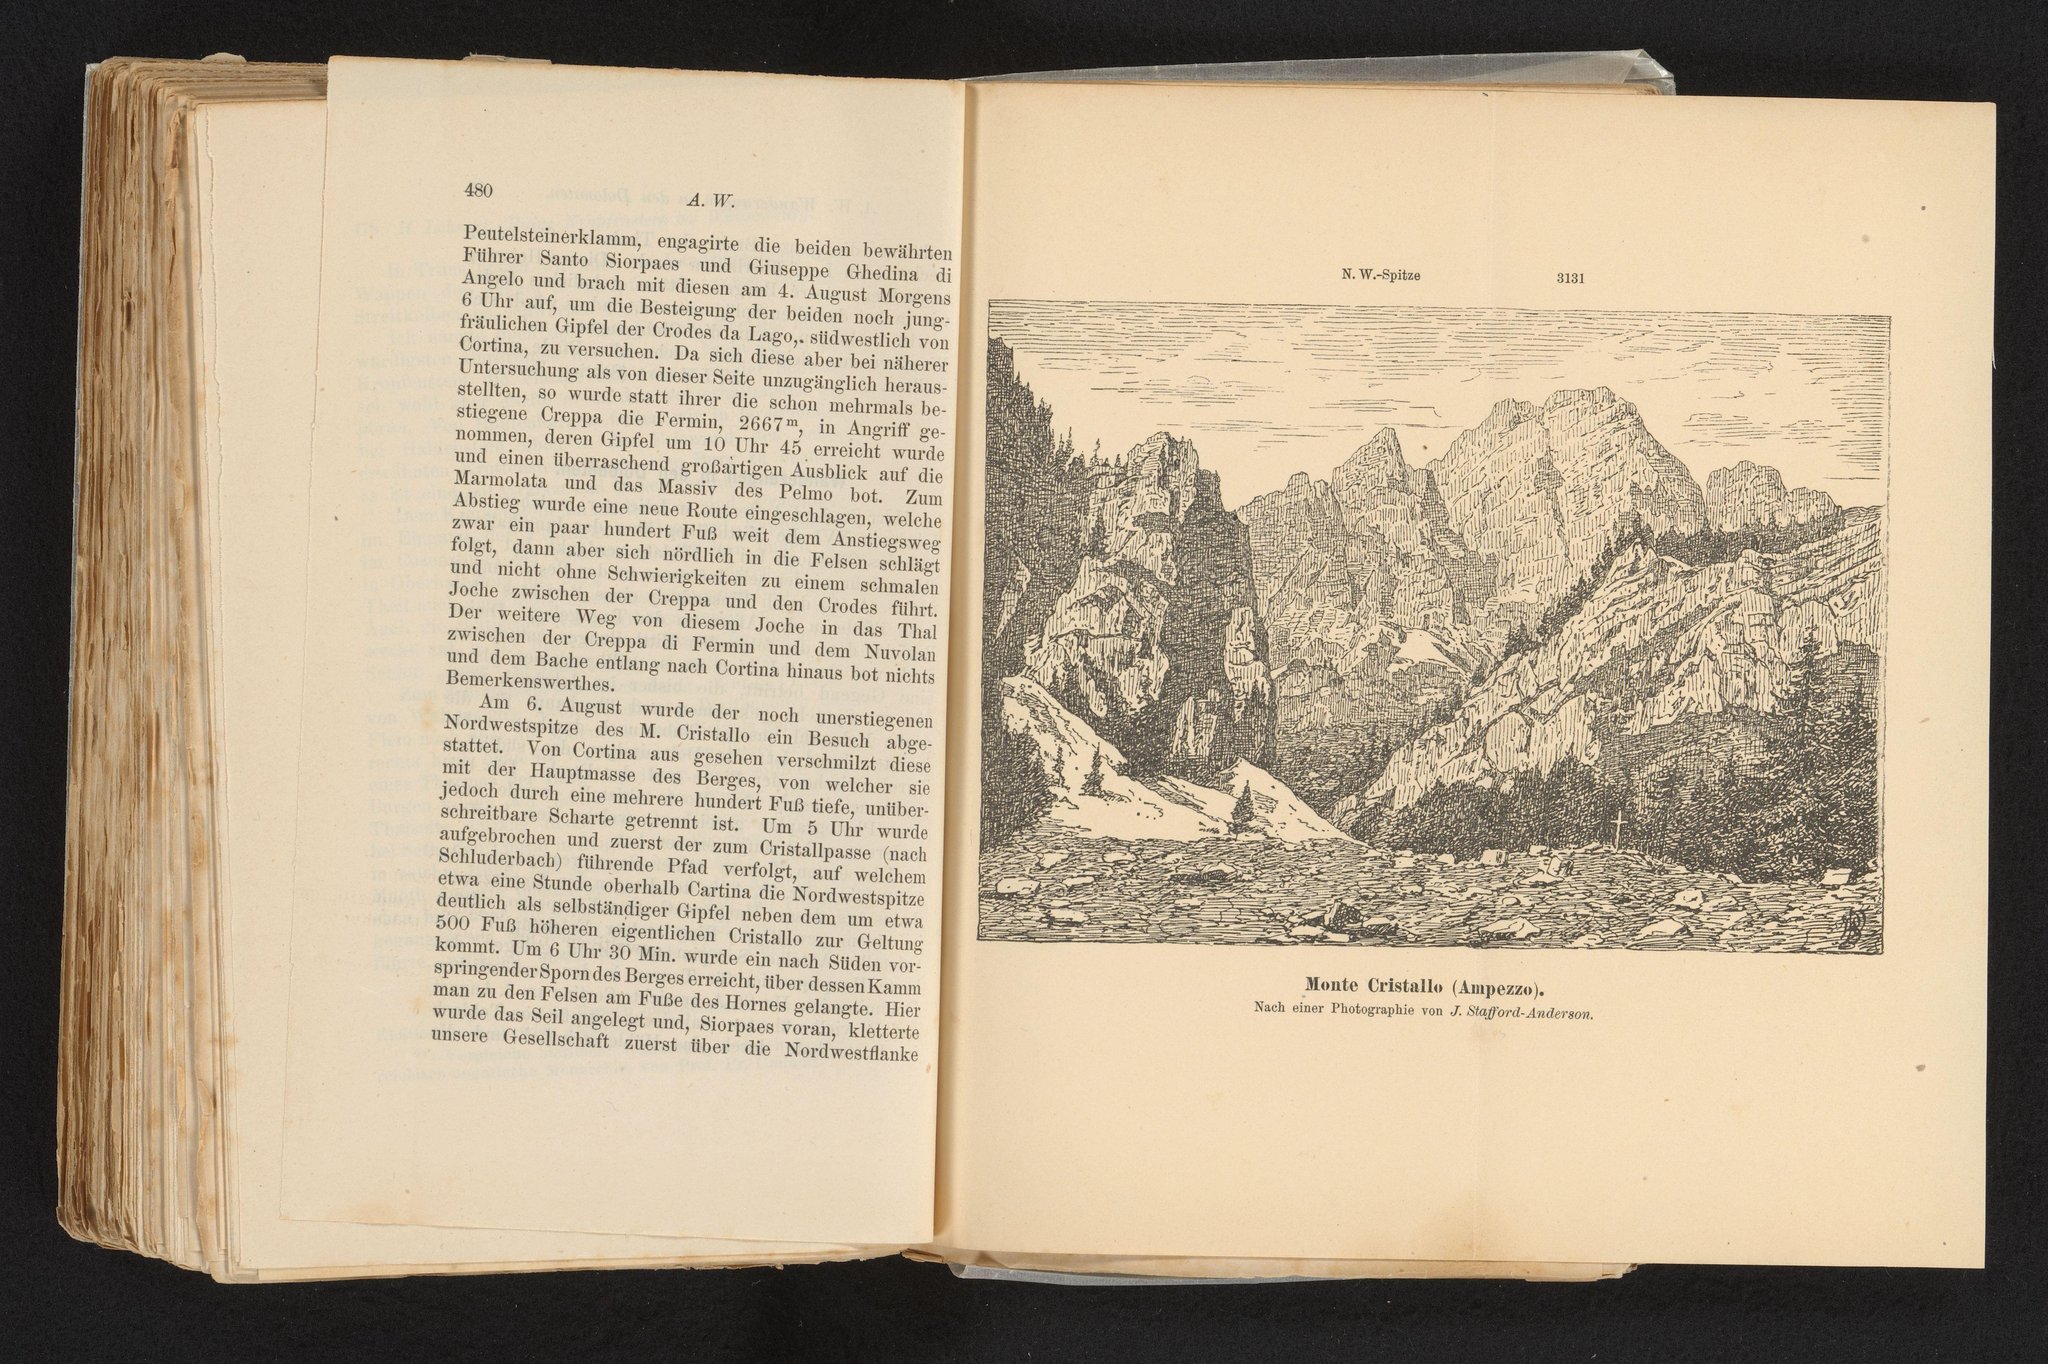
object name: reproduction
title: Reproductie van een prent van een gezicht op de berg Cristallo in de Alpen, Italië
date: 1877-1882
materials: paper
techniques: printing block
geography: alps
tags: mountain-range, snow peaks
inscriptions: inscription: ‘N. W.-Spitze - 3131’